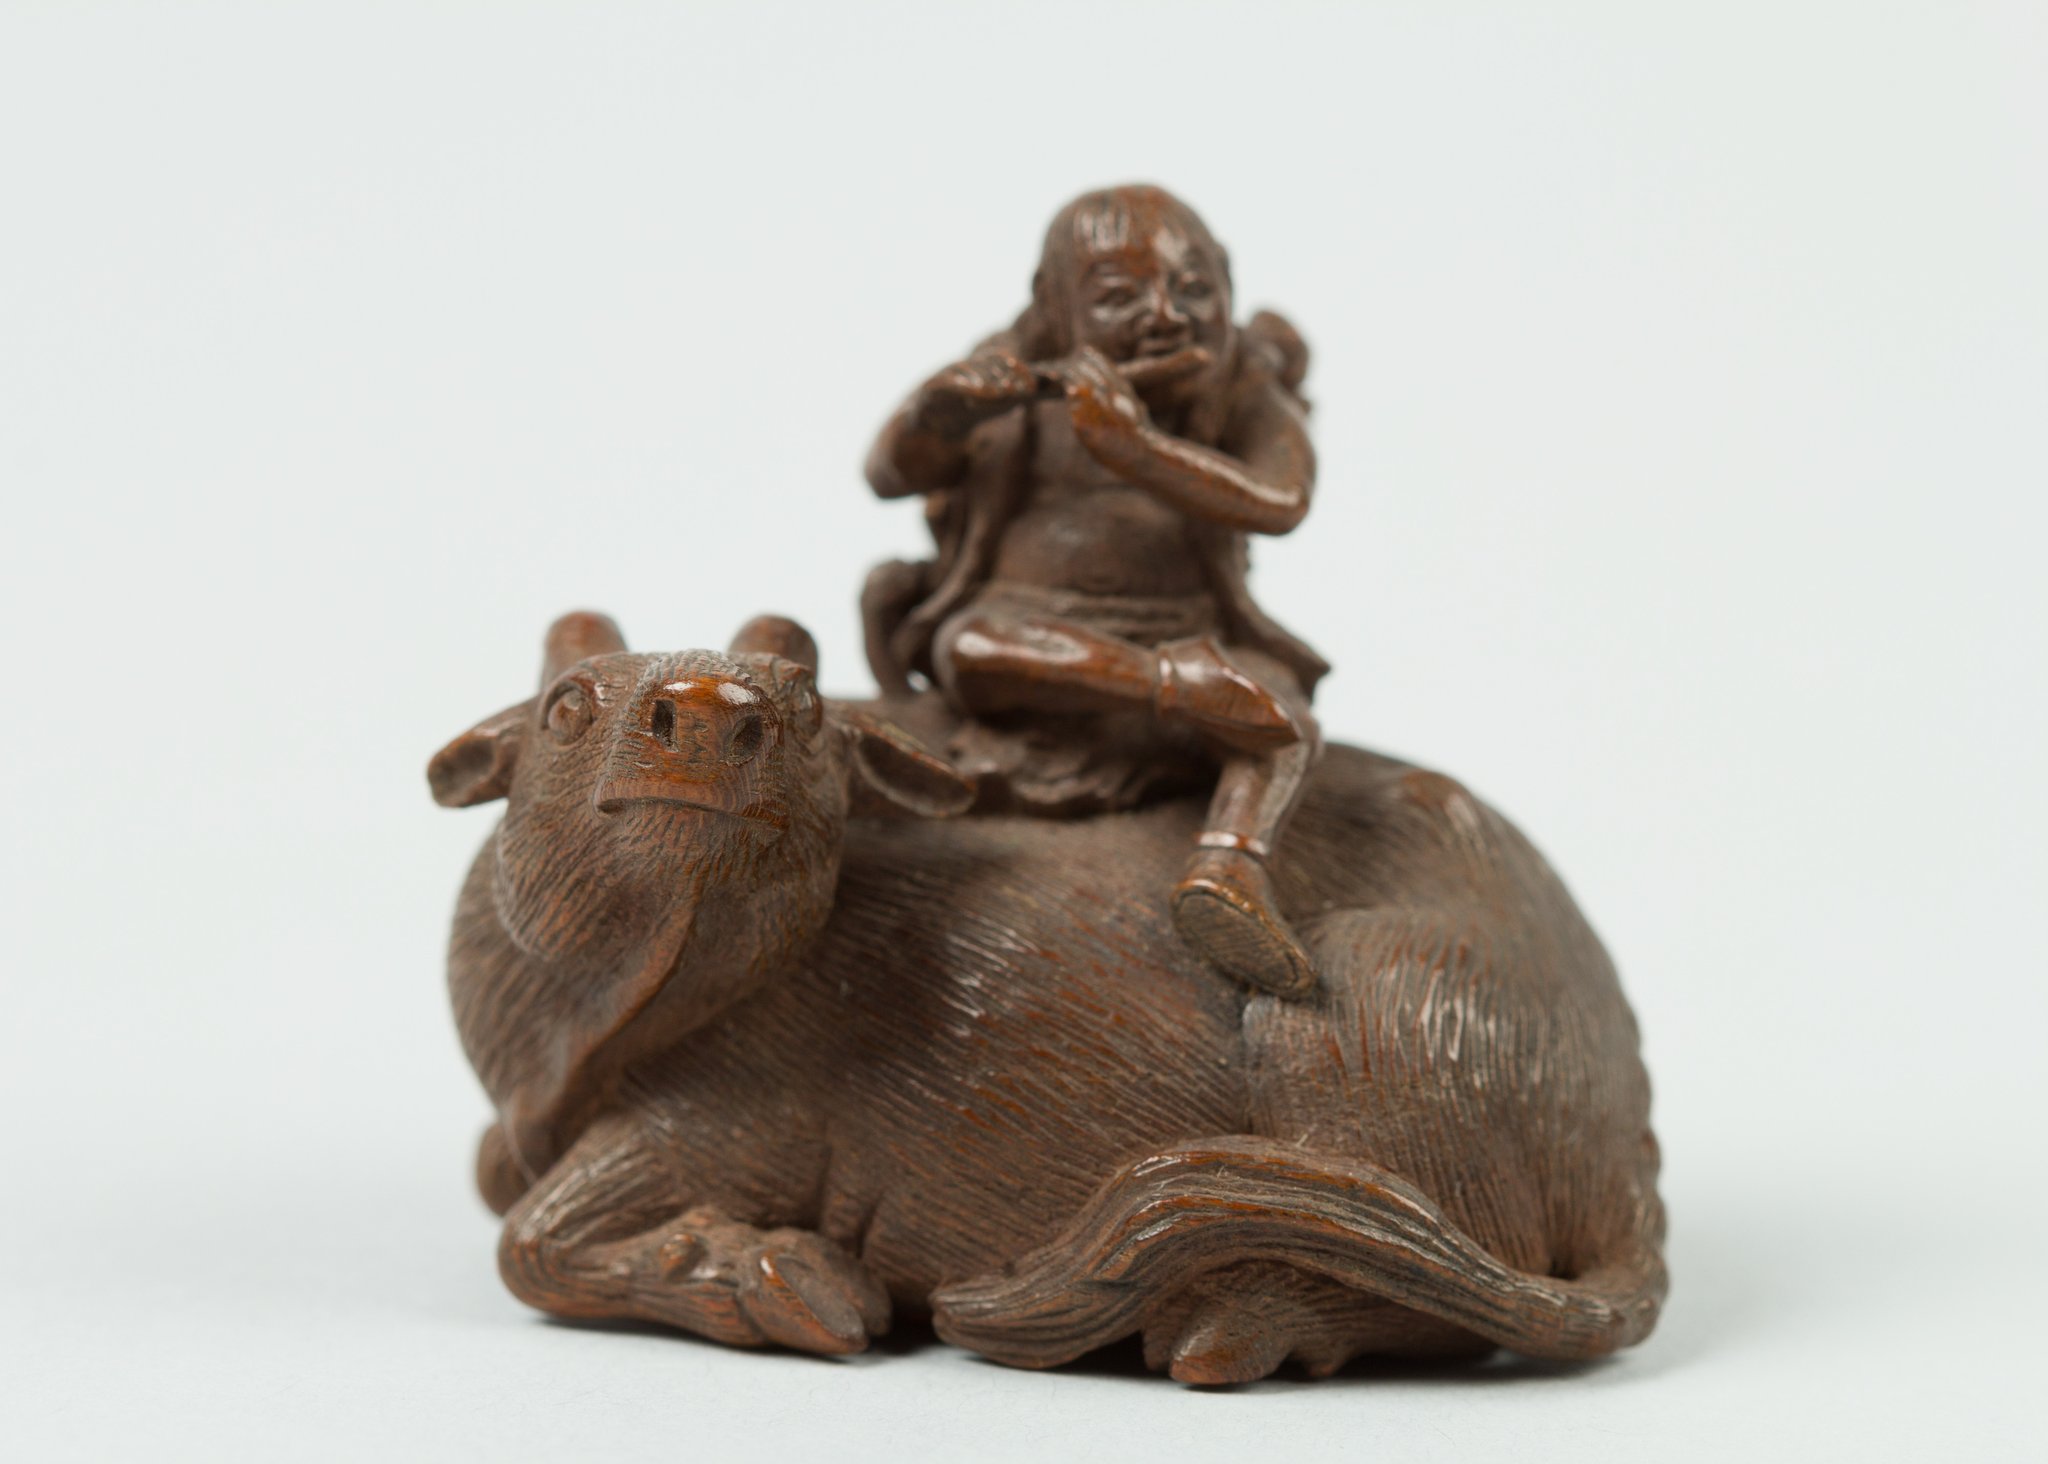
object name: netsuke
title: Netsuke of Man Playing Flute atop an Ox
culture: japanese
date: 1801-1900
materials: wood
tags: animals,flutes